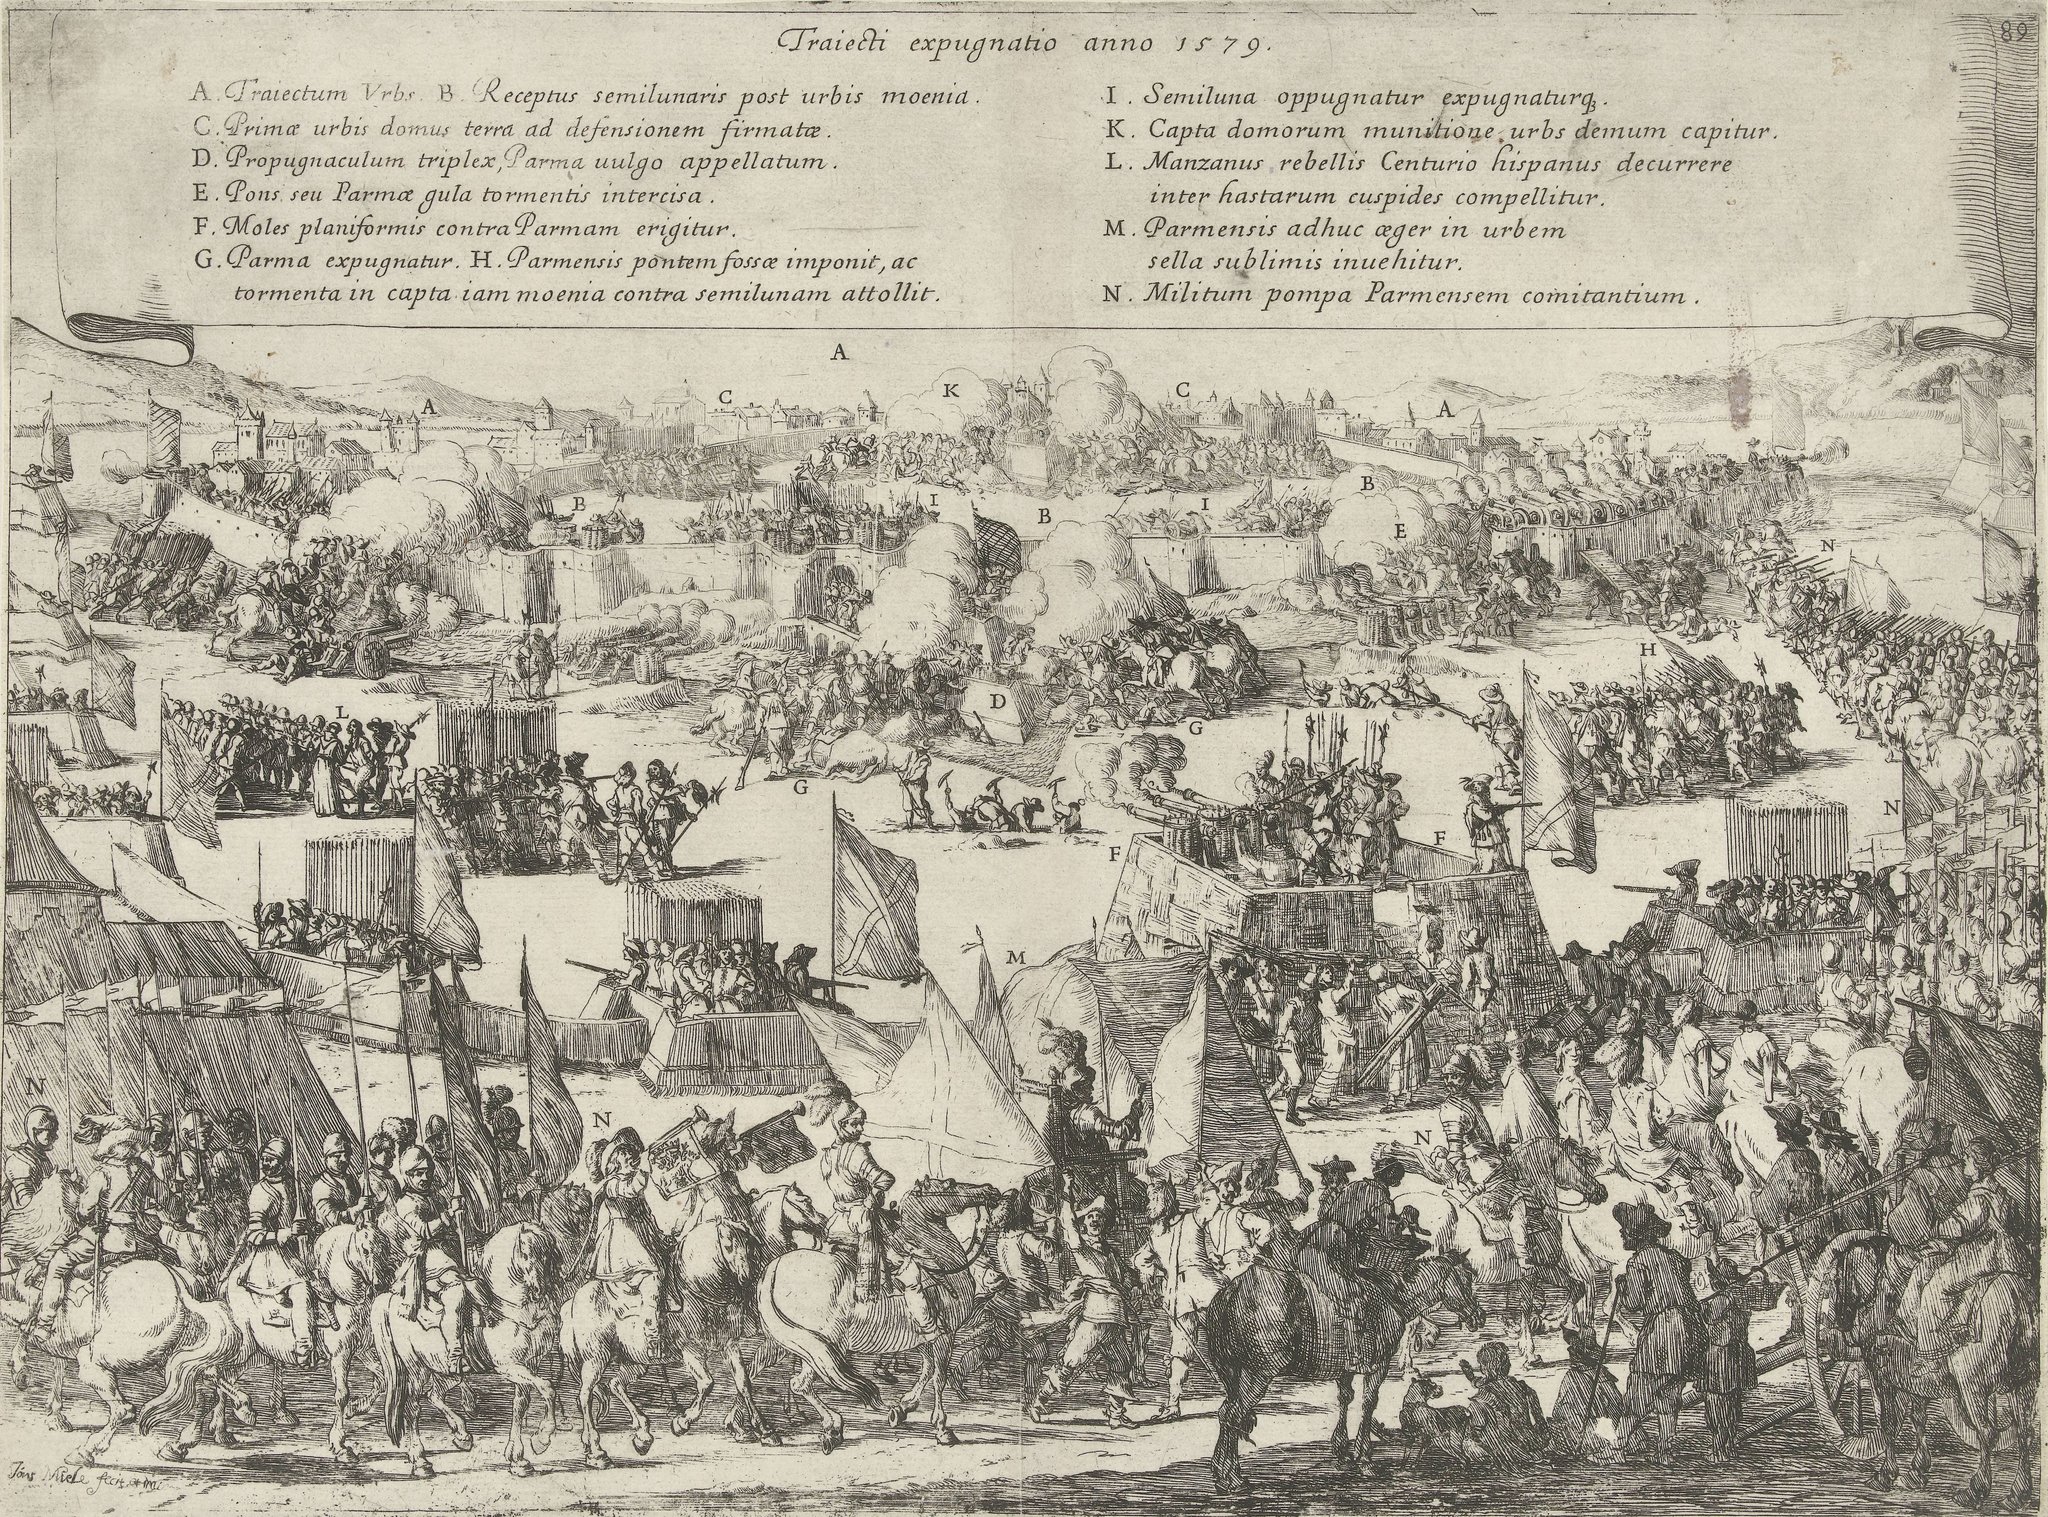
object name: print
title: Traiecti expugnatio anno 1579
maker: jan miel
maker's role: draughtsman, painter, print maker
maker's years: 1599-1663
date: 1645-1647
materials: paper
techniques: etching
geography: rome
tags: rome, alessandro farnese (landvoogd van de nederlanden en hertog van parma en piacenza), (carrying a person in a) sedan-chair, capture of city (after the siege), maastricht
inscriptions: inscription: ‘F.D. 1840’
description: Maastricht na beleg veroverd door het leger van Parma, 29 juni 1579. Voor de stadsmuren wordt nog geschoten en gevochten. Op de voorgrond de stoet met de hertog van Parma in een draagstoel die naar rechts en de stad in trekt. Bovenin een banderol met de titel en de legenda A-N in het Latijn.